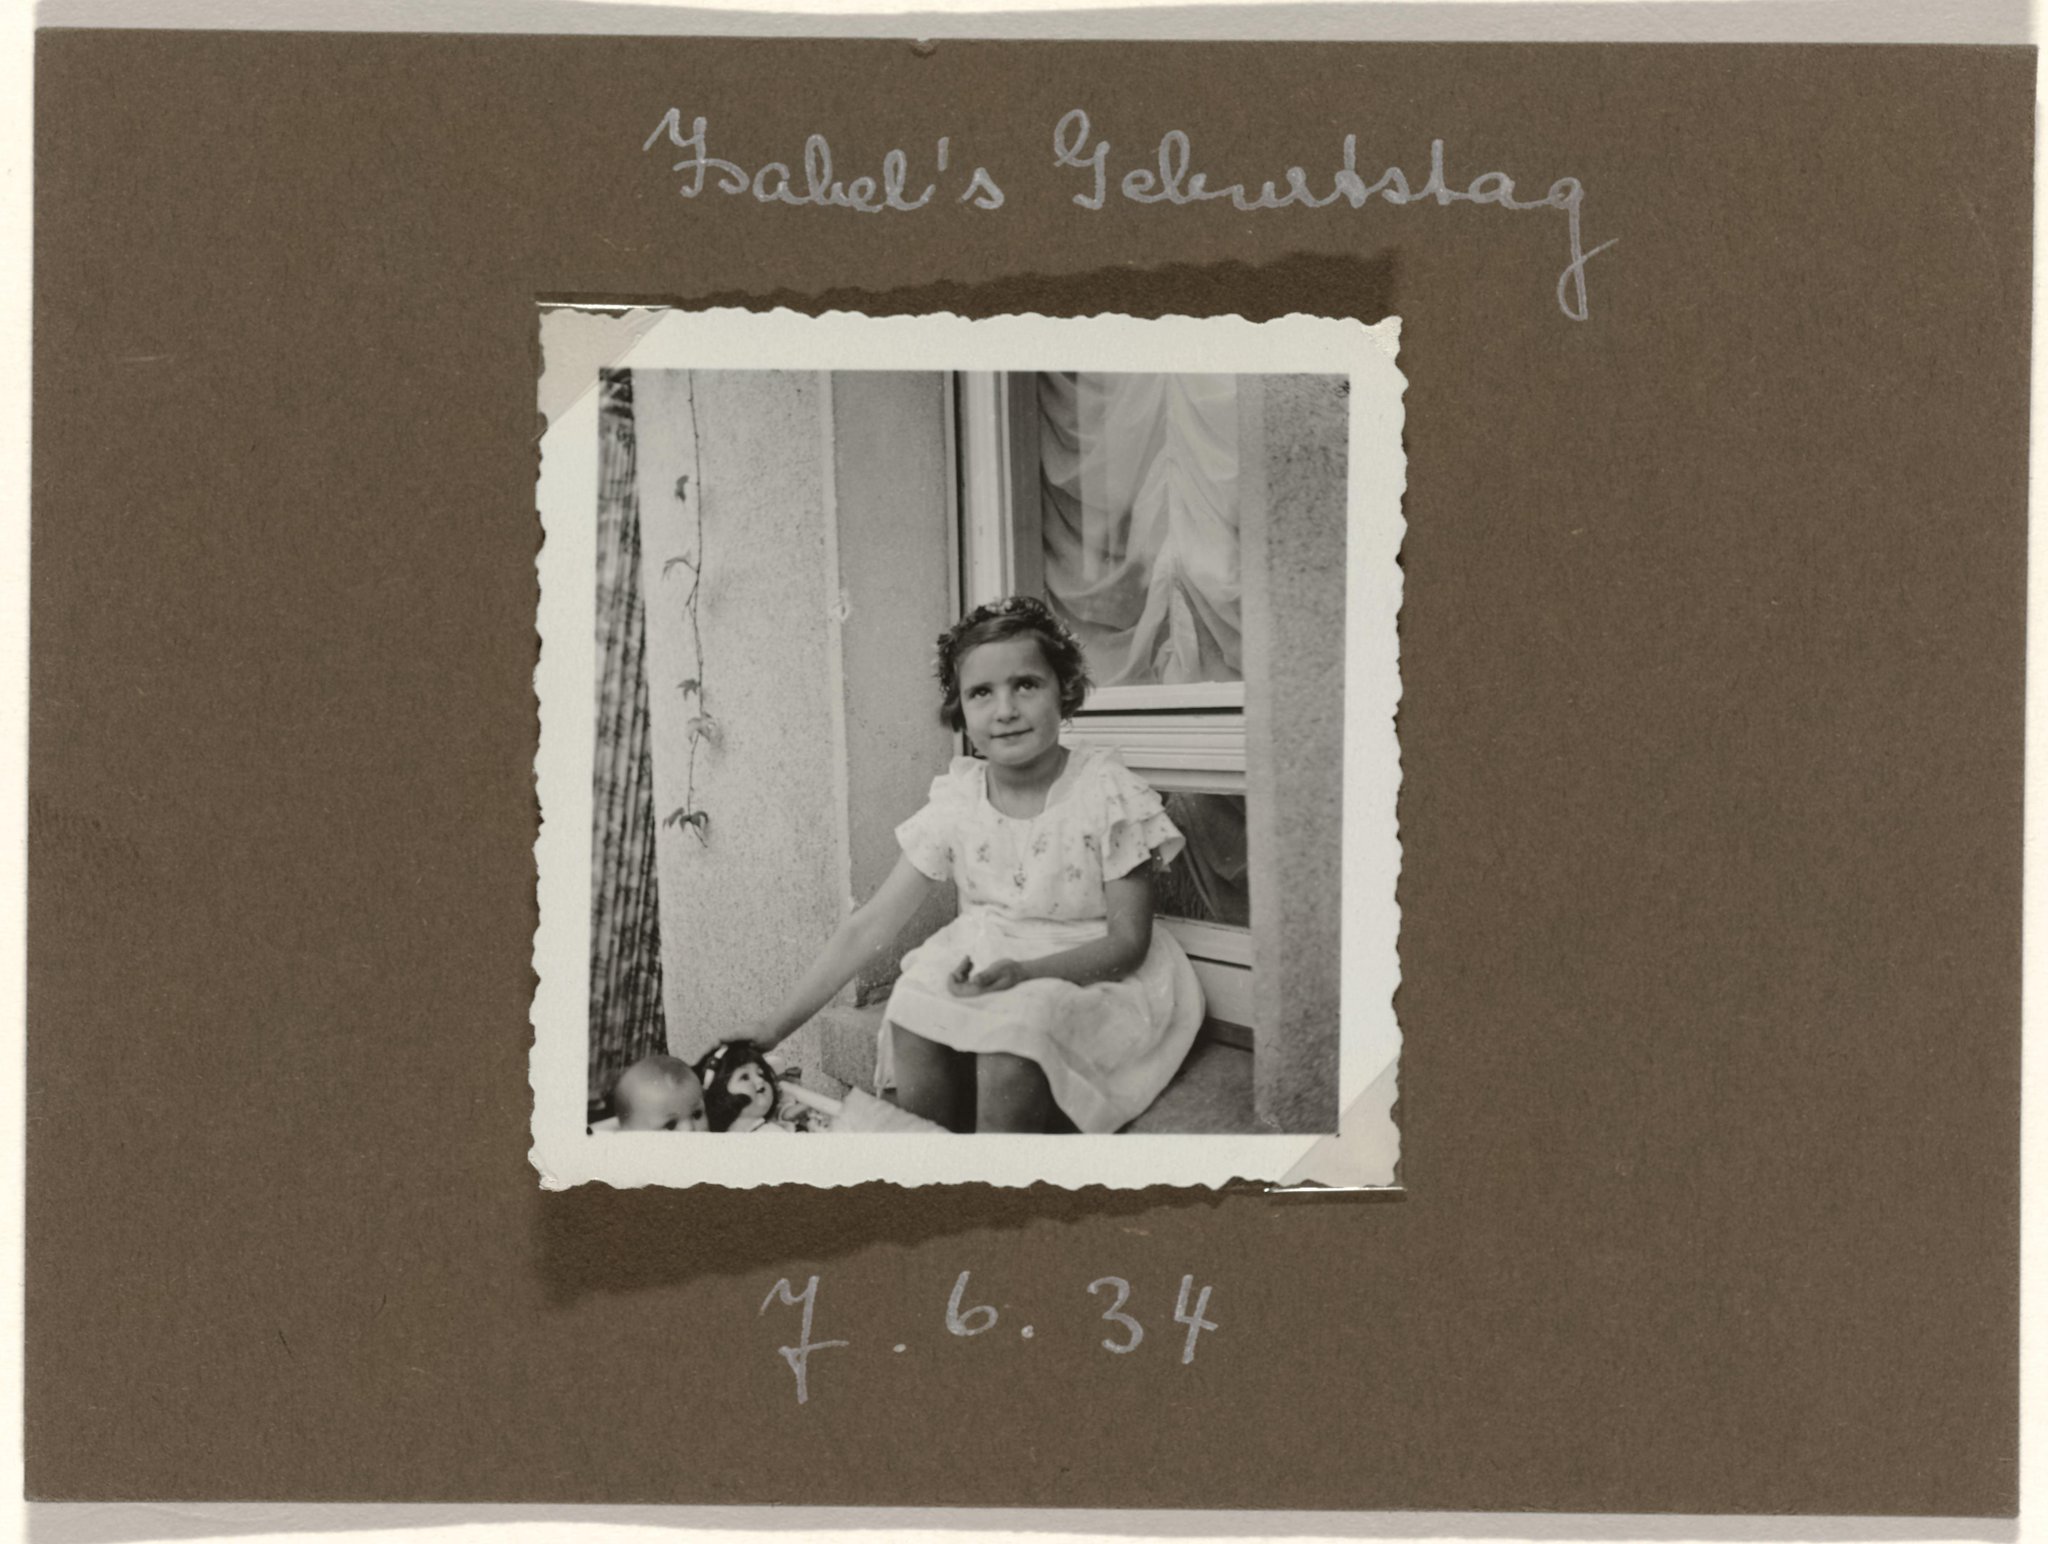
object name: photograph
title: Isabel op haar verjaardag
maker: Anonymous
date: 1934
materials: photographic support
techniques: gelatin silver print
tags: leiden, isabel wachenheimer-elon